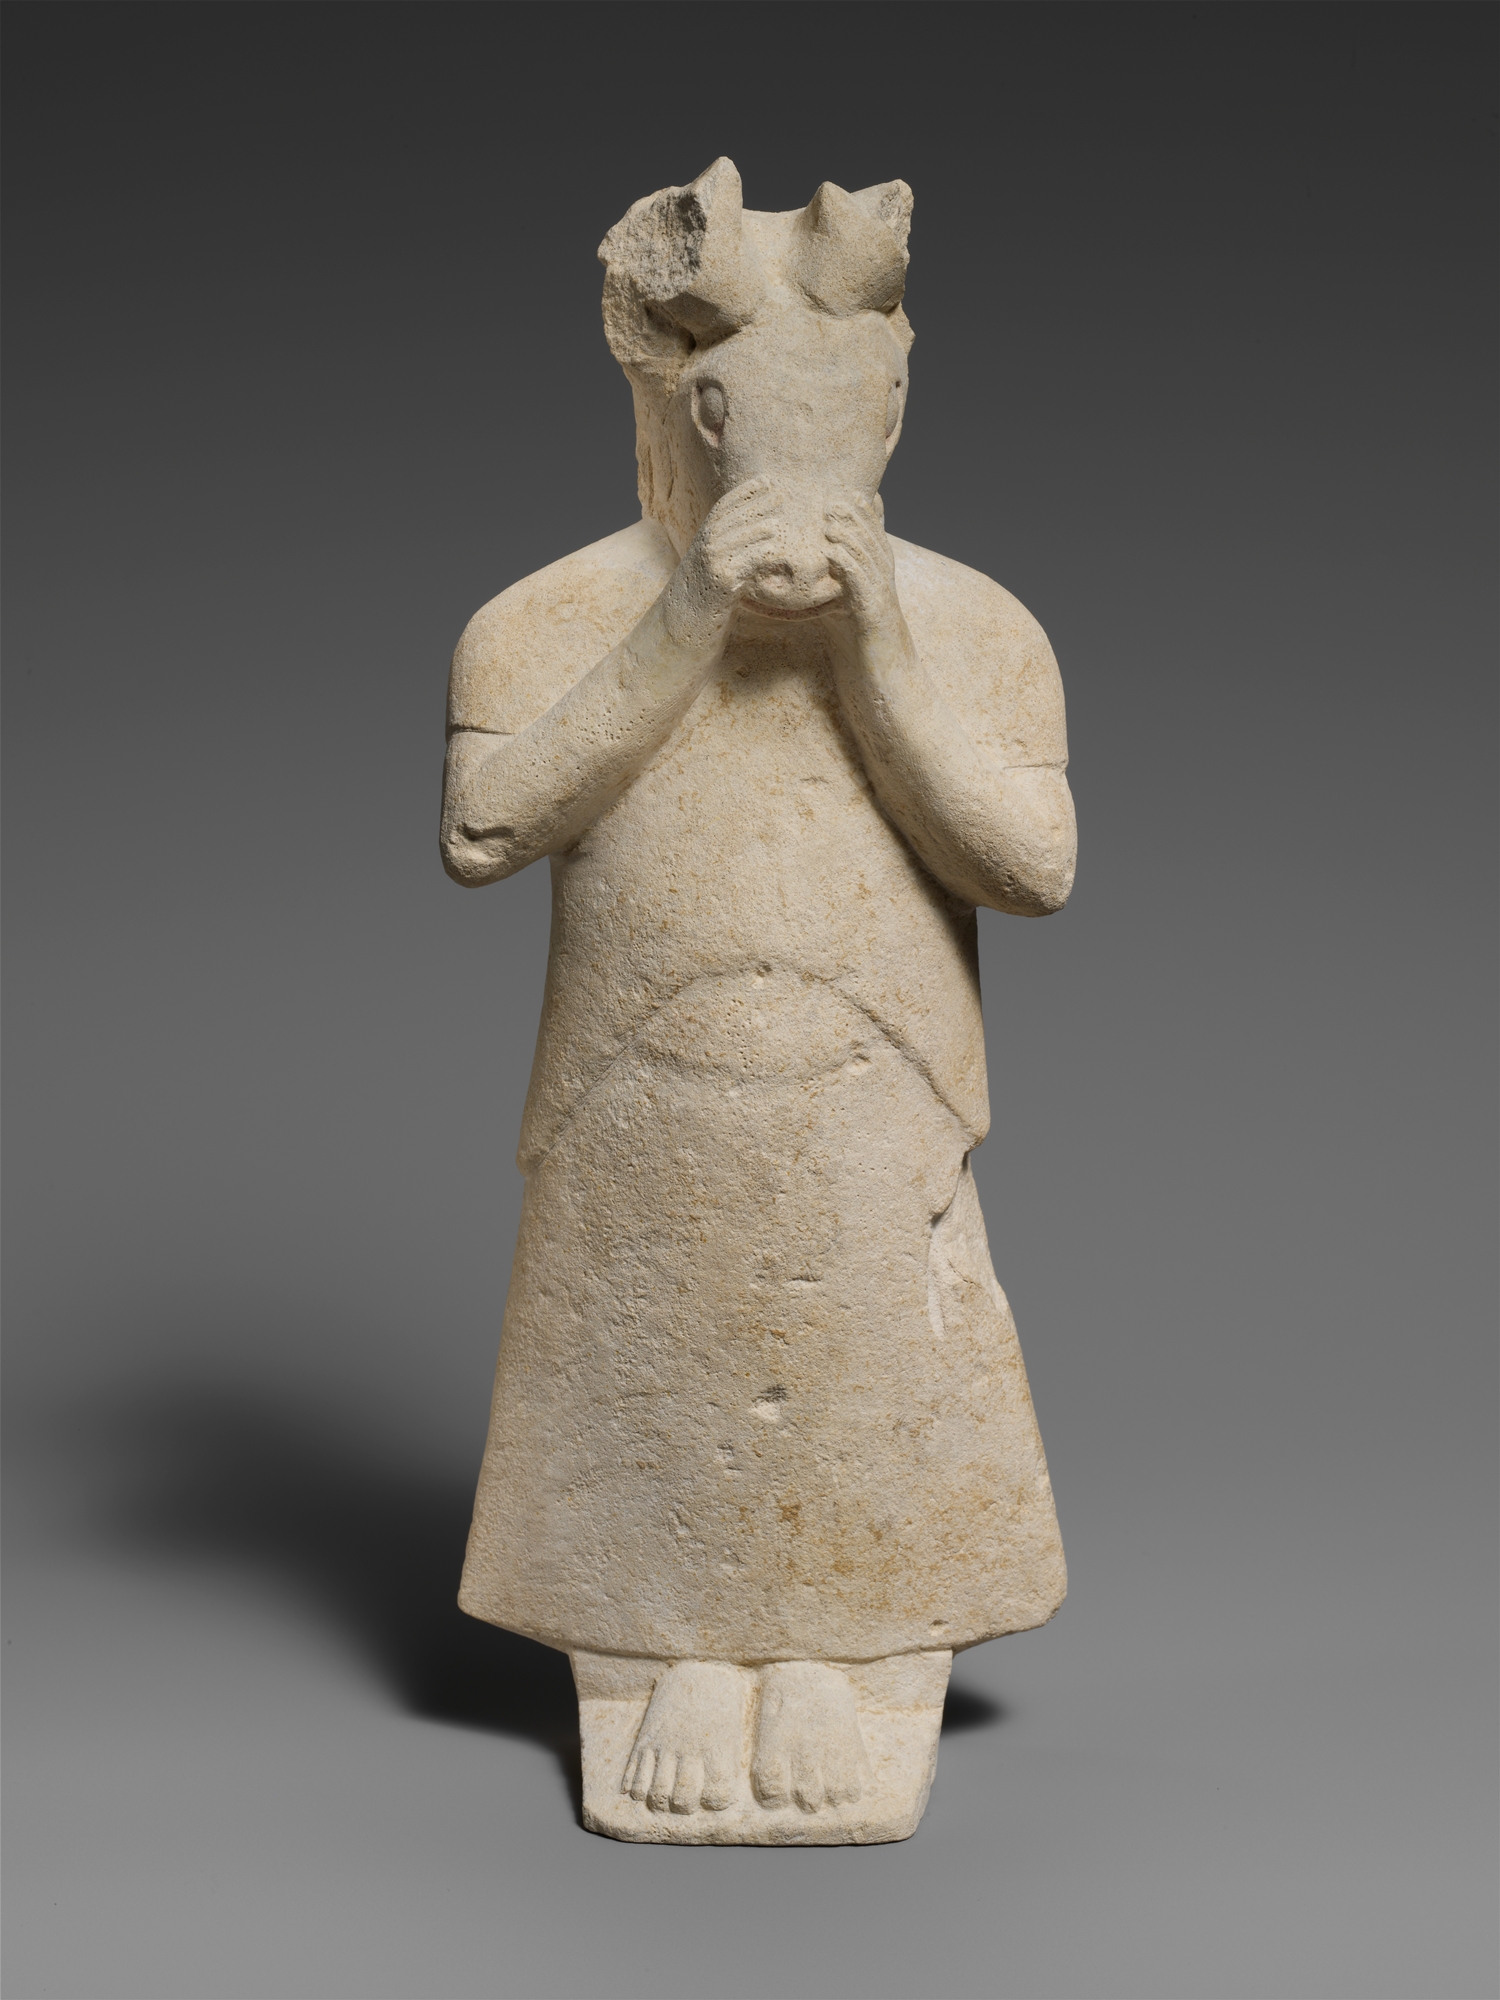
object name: statuette of a figure with a mask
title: Limestone figure with mask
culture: cypriot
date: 600-501 BCE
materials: limestone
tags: human figures,masks